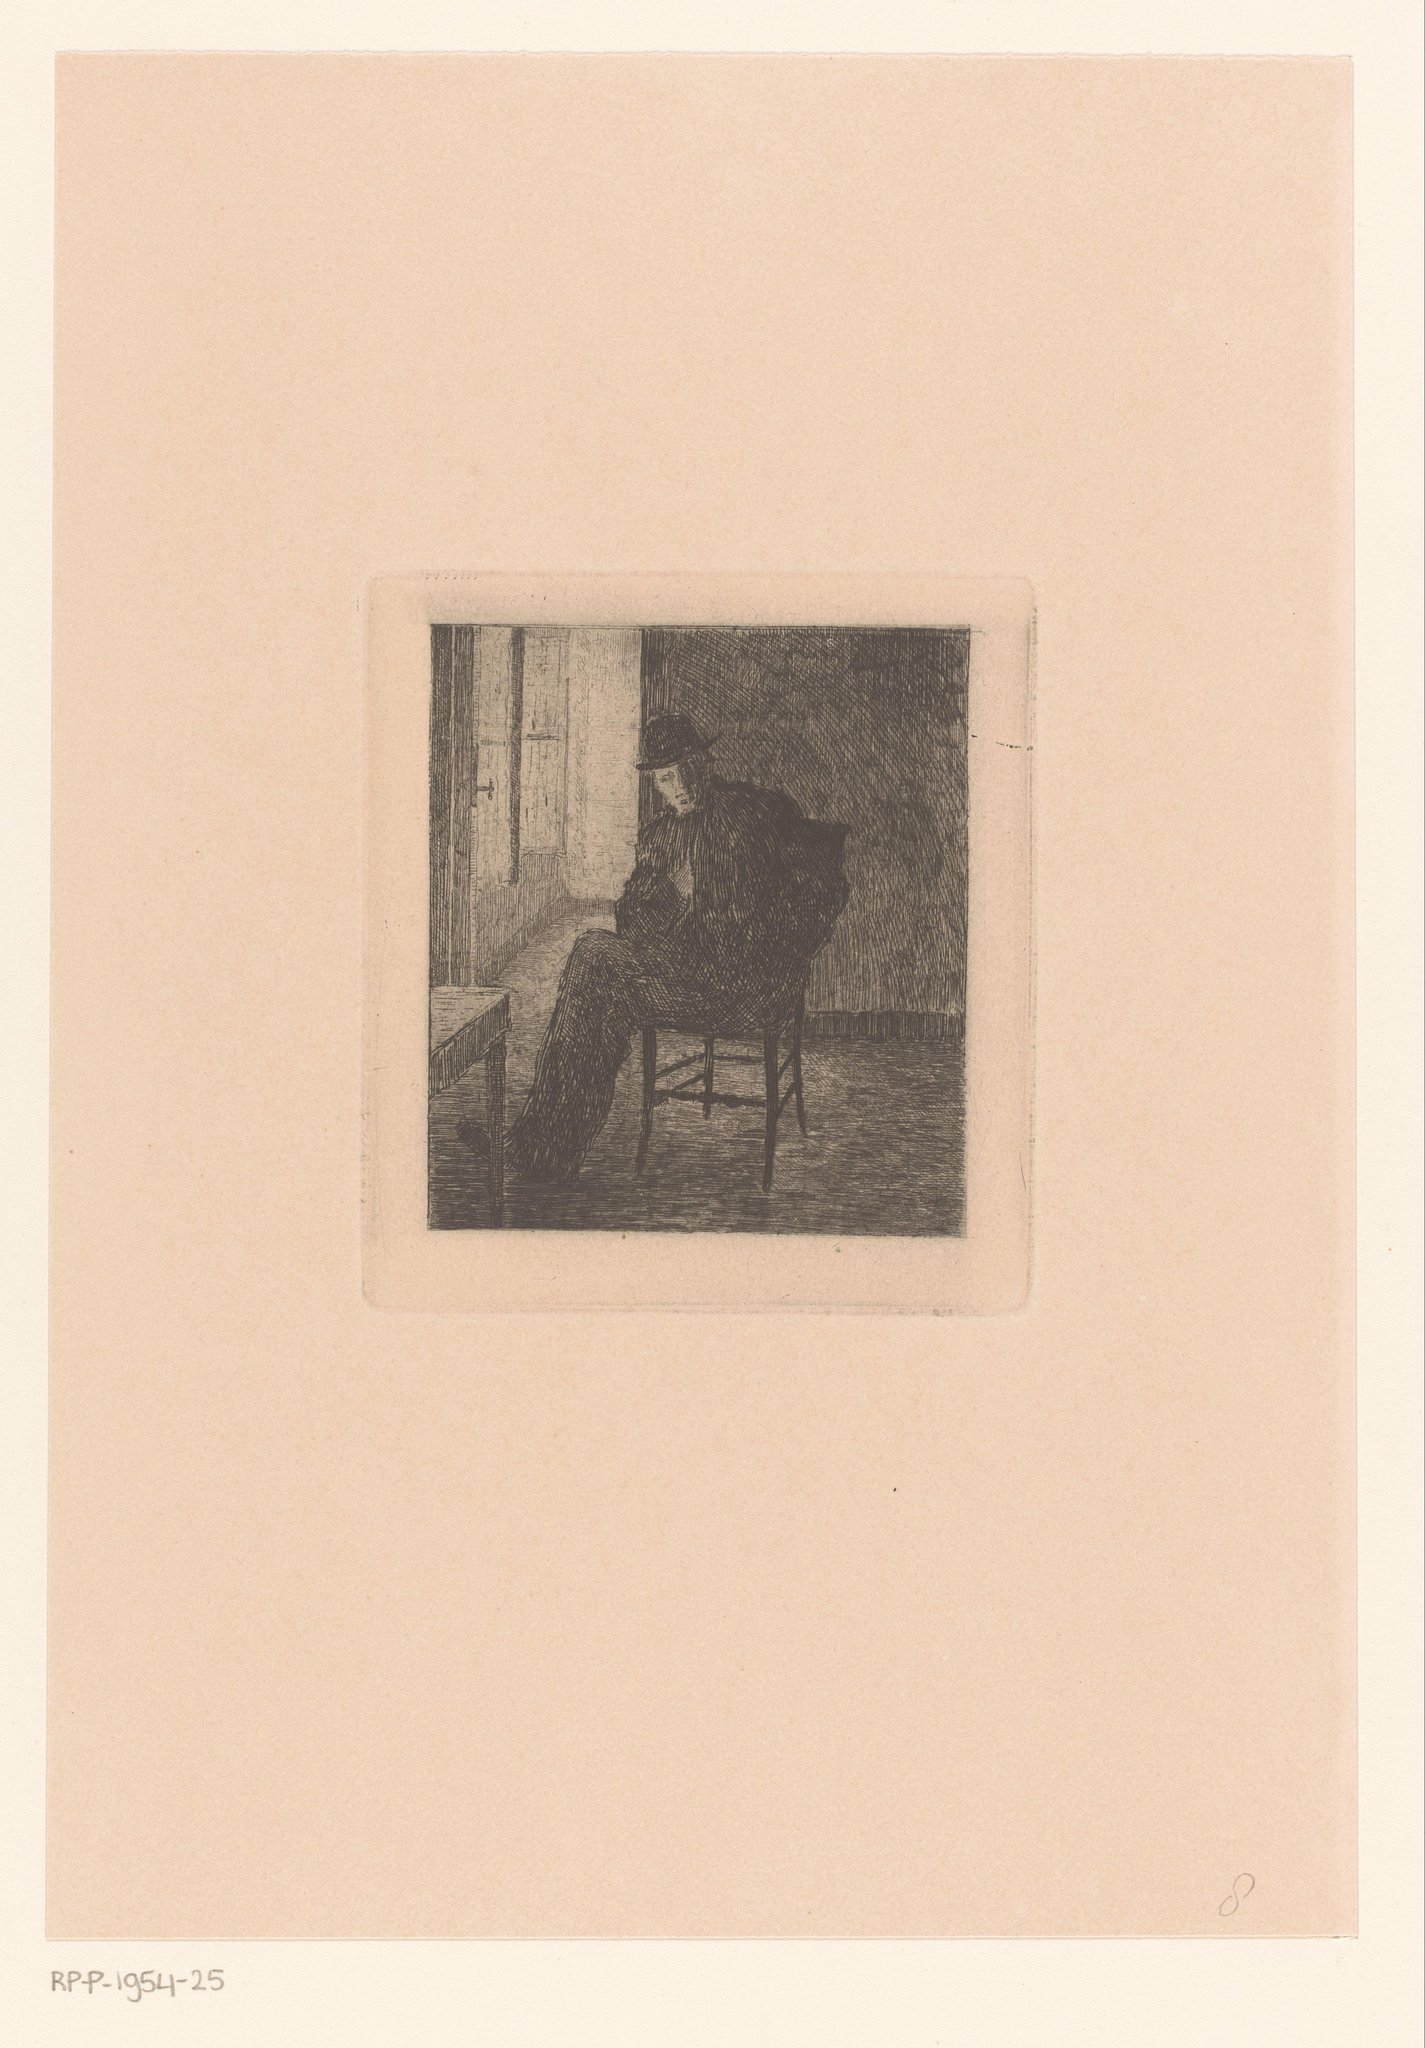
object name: print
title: Zelfportret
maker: rik wouters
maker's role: draughtsman, print maker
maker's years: 1882-1916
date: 1892-1916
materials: paper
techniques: etching, intaglio, retroussage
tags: mechelen, amsterdam, print maker, draughtsman, rik wouters, adult man (+ sitting), historical persons, portrait, self-portrait of graphic artist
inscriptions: collector's mark: Lugt 2228